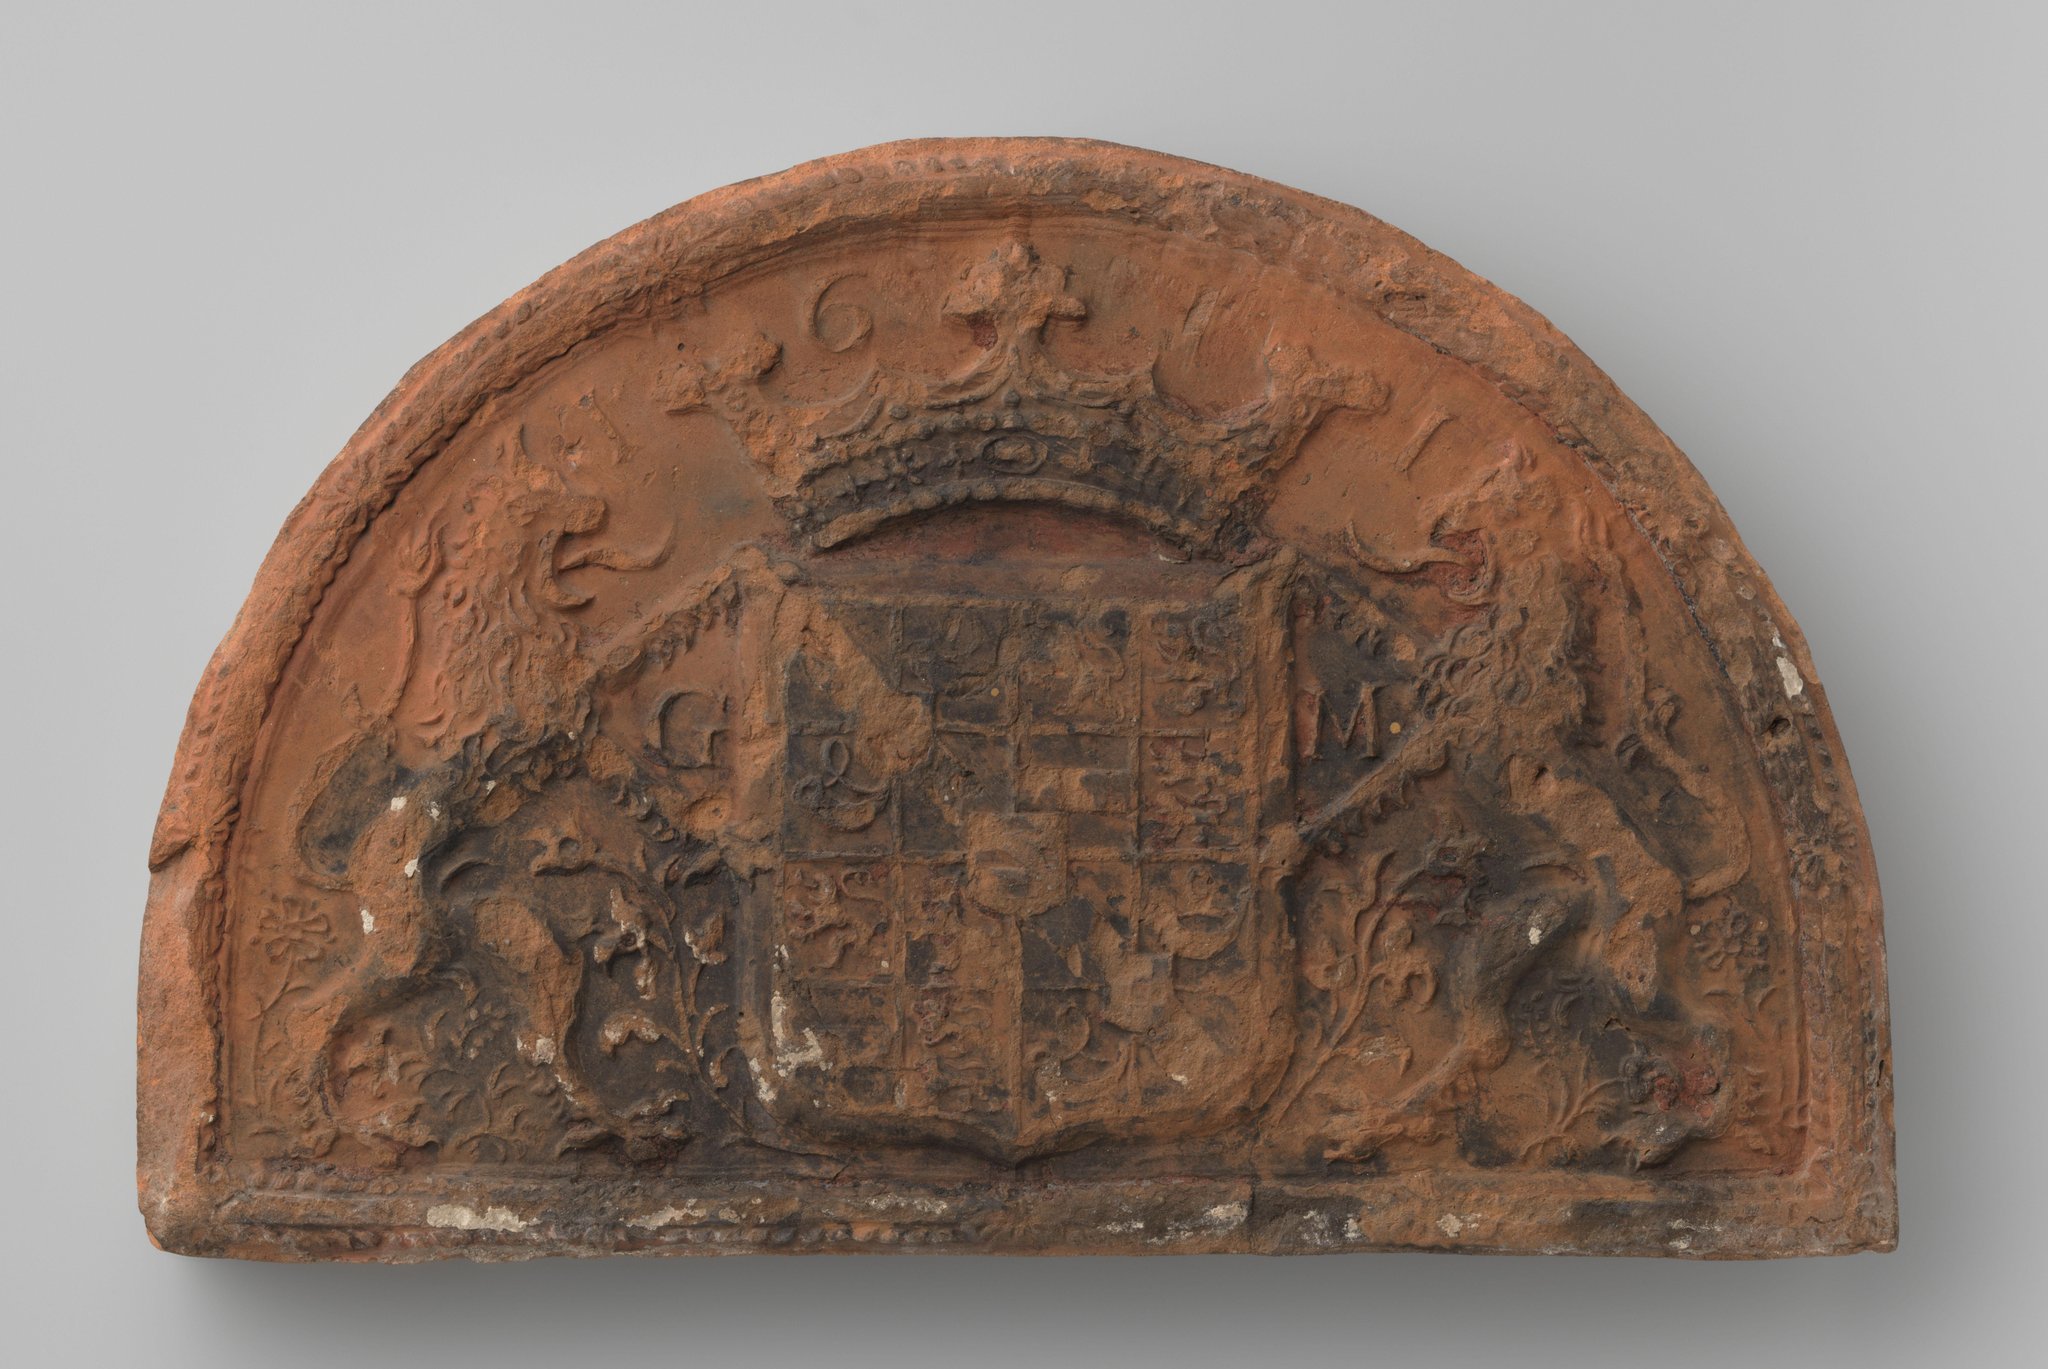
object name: haarddeksteen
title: Haarddeksteen met het wapen van Prins Maurits van Oranje Nassau.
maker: Anonymous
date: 1611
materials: brick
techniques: printing, firing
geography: netherlands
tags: the hague, maurice (prince of orange)